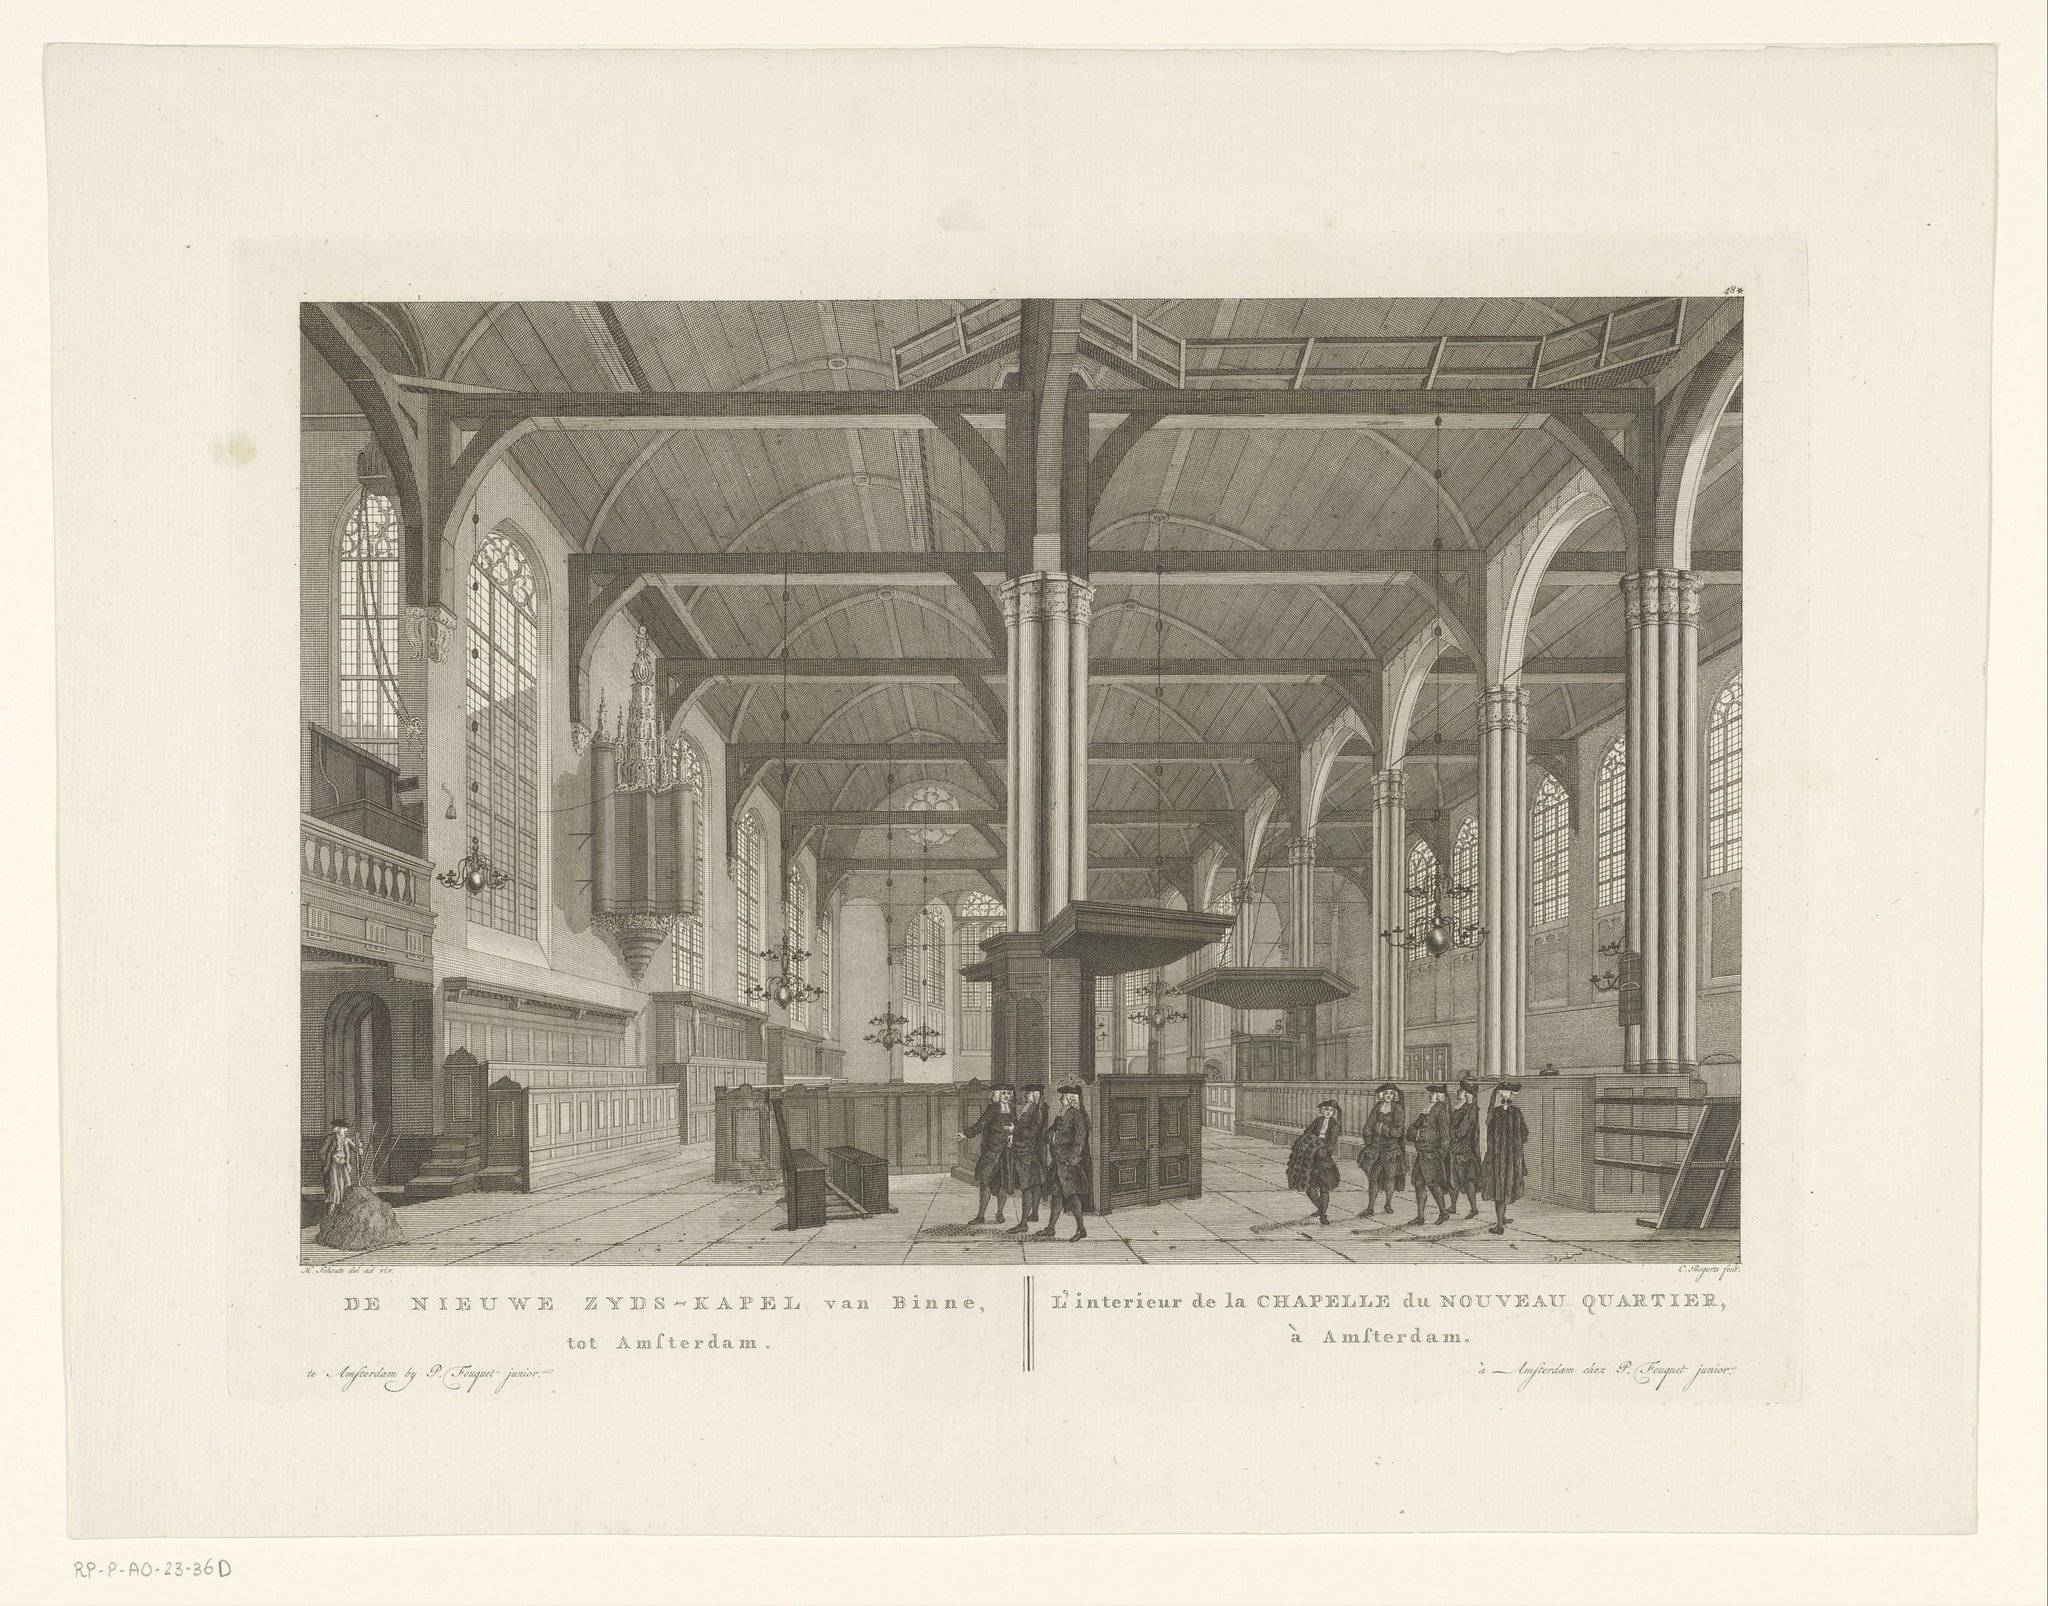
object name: print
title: Interieur van de Nieuwezijds Kapel te Amsterdam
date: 1770-1783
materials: paper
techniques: engraving, etching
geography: amsterdam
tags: interior of church, church (exterior) - qq - small church, chapel, grave digger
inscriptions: collector's mark: Lugt 2228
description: Deze prent is ook gebruikt in de zogenaamde Atlas van Fouquet.* Pierre Fouquet gaf vanaf 1760 stadsgezichten van Amsterdam - naar tekeningen van verschillende kunstenaars, gemaakt door verschillende prentmakers - uit. Deze prenten werden aanvankelijk los of in series verkocht. Zoals toen gebruikelijk kon de koper de prenten zelf laten inbinden. Hiertoe gaf Fouquet tussen 1778 en 1783 een titelblad, plattegrond en inhoudsopgave van de tot dusver 100 uitgegeven prenten uit (1). Gezien de inhoud afhankelijk was van wat de koper had verzameld verschilt de inhoud van de verschillende bewaarde Fouquetatlassen onder deze titel sterk. Ook zijn er exemplaren bekend waar tevens andere prenten aan zijn toegevoegd. Omdat er behoefte bleek aan uitleg bij de platen werd in 1783 een nieuwe versie van de atlas uitgegeven, aangevuld met tekst en twee prenten. De aangegeven volgorde veranderde maar de platen van de al eerder uitgegeven prenten bleven ongewijzigd. Deze uitgave werd in opdracht van Fouquet gedrukt bij Daniël Jean Changuion en Petrus den Hengst (2). Een tiental platen werd bijgewerkt en verscheen, met nieuw impressum, in het vervolg van Wagenaars geschiedenis van Amsterdam, uitgeven door Petrus Conradi en Folkert van der Plaats (3). Een aantal jaar na het overlijden van Fouquet kwam Evert Maaskamp met een nieuwe uitgave van de atlas, met verbeterde tekst en toevoeging van twee prenten. Op alle platen verwijderde hij het oude en liet hij zijn eigen impressum zetten (4). De huidige staat van de prent komt voor in exemplaren van de onder (1) en (2) genoemde werken. * Onder de Atlas van Fouquet of Fouquetatlas verstaan we de hieronder vermelde publicaties (1), (2) en (4). (1). Afbeeldingen van de wyd-vermaarde koopstad Amsterdam benevens des zelvs voornaamste gebouwen en gezigten alle naar het leeven getekend / Receuil des edifices les plus considerables et des plus belles vues, de la fameuse ville d'Amsterdam, dessinées d'après nature. Amsterdam: Pierre Fouquet, 1778-1783. (2). Nieuwe atlas, van de voornaamste gebouwen en gezigten der stad Amsterdam, met derzelver beknopte beschryvingen. 2 delen. Amsterdam: Daniël Jean Changuion en Petrus den Hengst [in opdracht van Pierre Fouquet], 1783. (3). Stijl, Simon. Amsterdam, in zyne geschiedenissen, voorregten, koophandel, gebouwen, kerkenstaat, schoolen, schutterye, gilden en regeeringe, beschreeven. Om te dienen ten vervolge op het werk van Jan Wagenaar (…). 10 delen. Amsterdam en Harlingen: Petrus Conradi en Folkert van der Plaats, 1788-1801. (4). Nieuwe atlas, van de voornaamste gebouwen en gezigten der stad Amsterdam. Met derzelver beknopte beschryvingen. Amsterdam: Evert Maaskamp, 1805. * Het aantal vermelde staten is gebaseerd op het aantal gevonden staten. Mogelijk zijn er meer staten van deze prent.